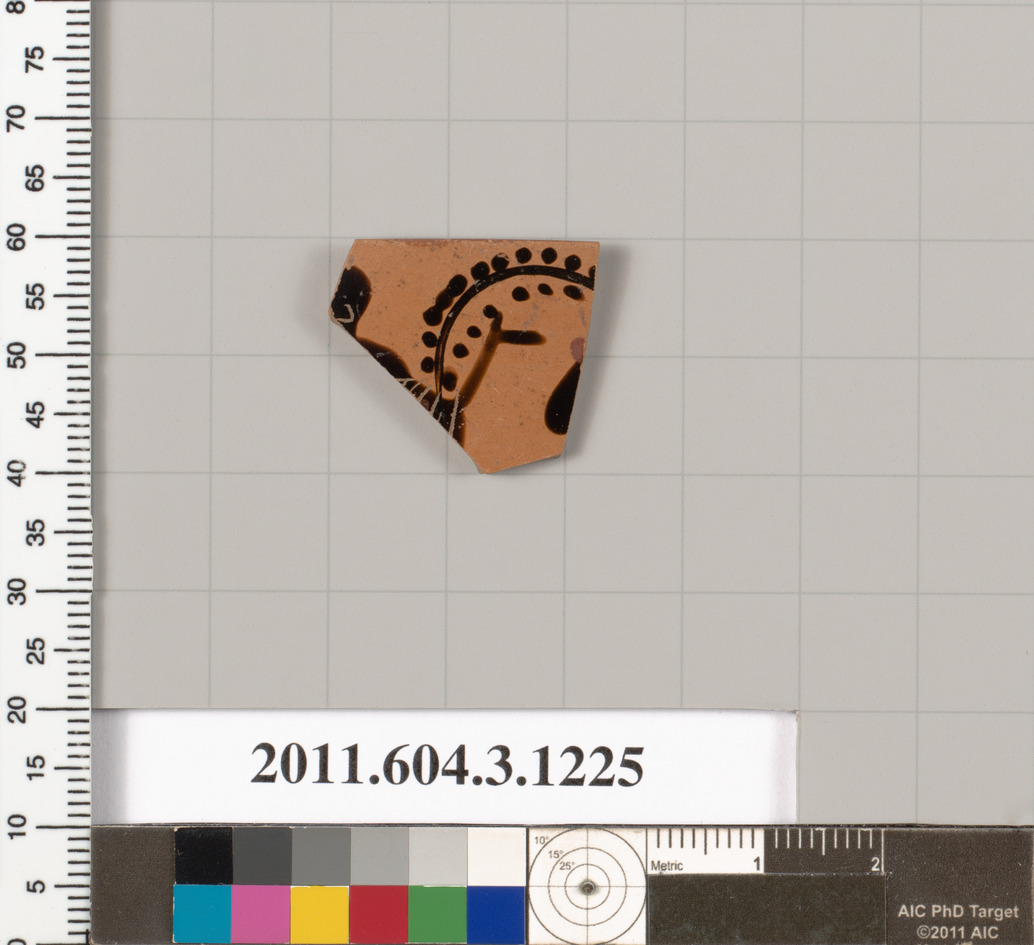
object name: kyathos fragment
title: Terracotta rim fragment of a kyathos (cup-shaped ladle)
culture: greek, attic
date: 534-468 BCE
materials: terracotta